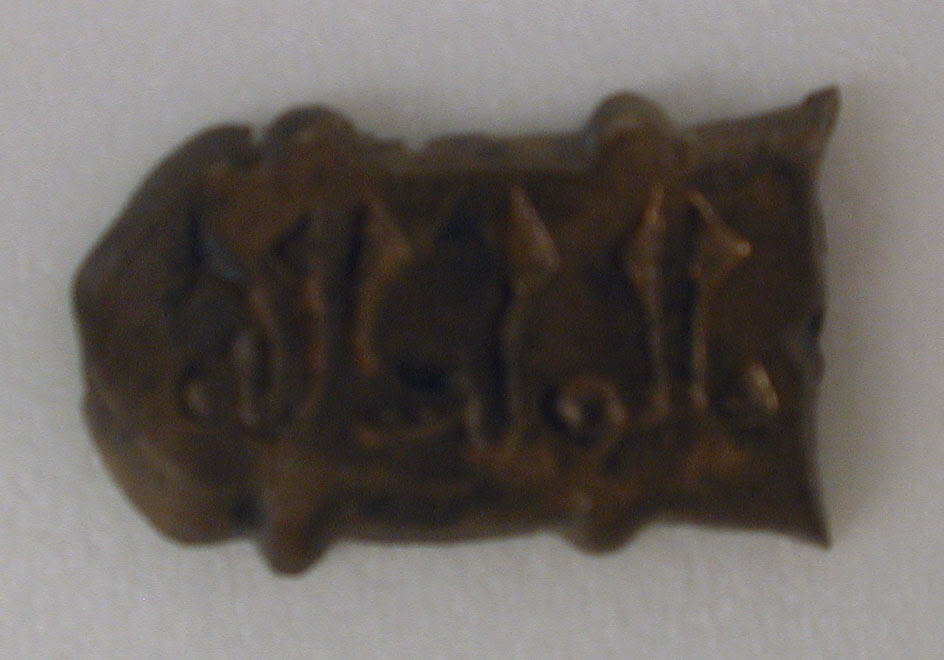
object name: belt fitting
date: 901-1000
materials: bronze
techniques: casting, gilding, incising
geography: iran